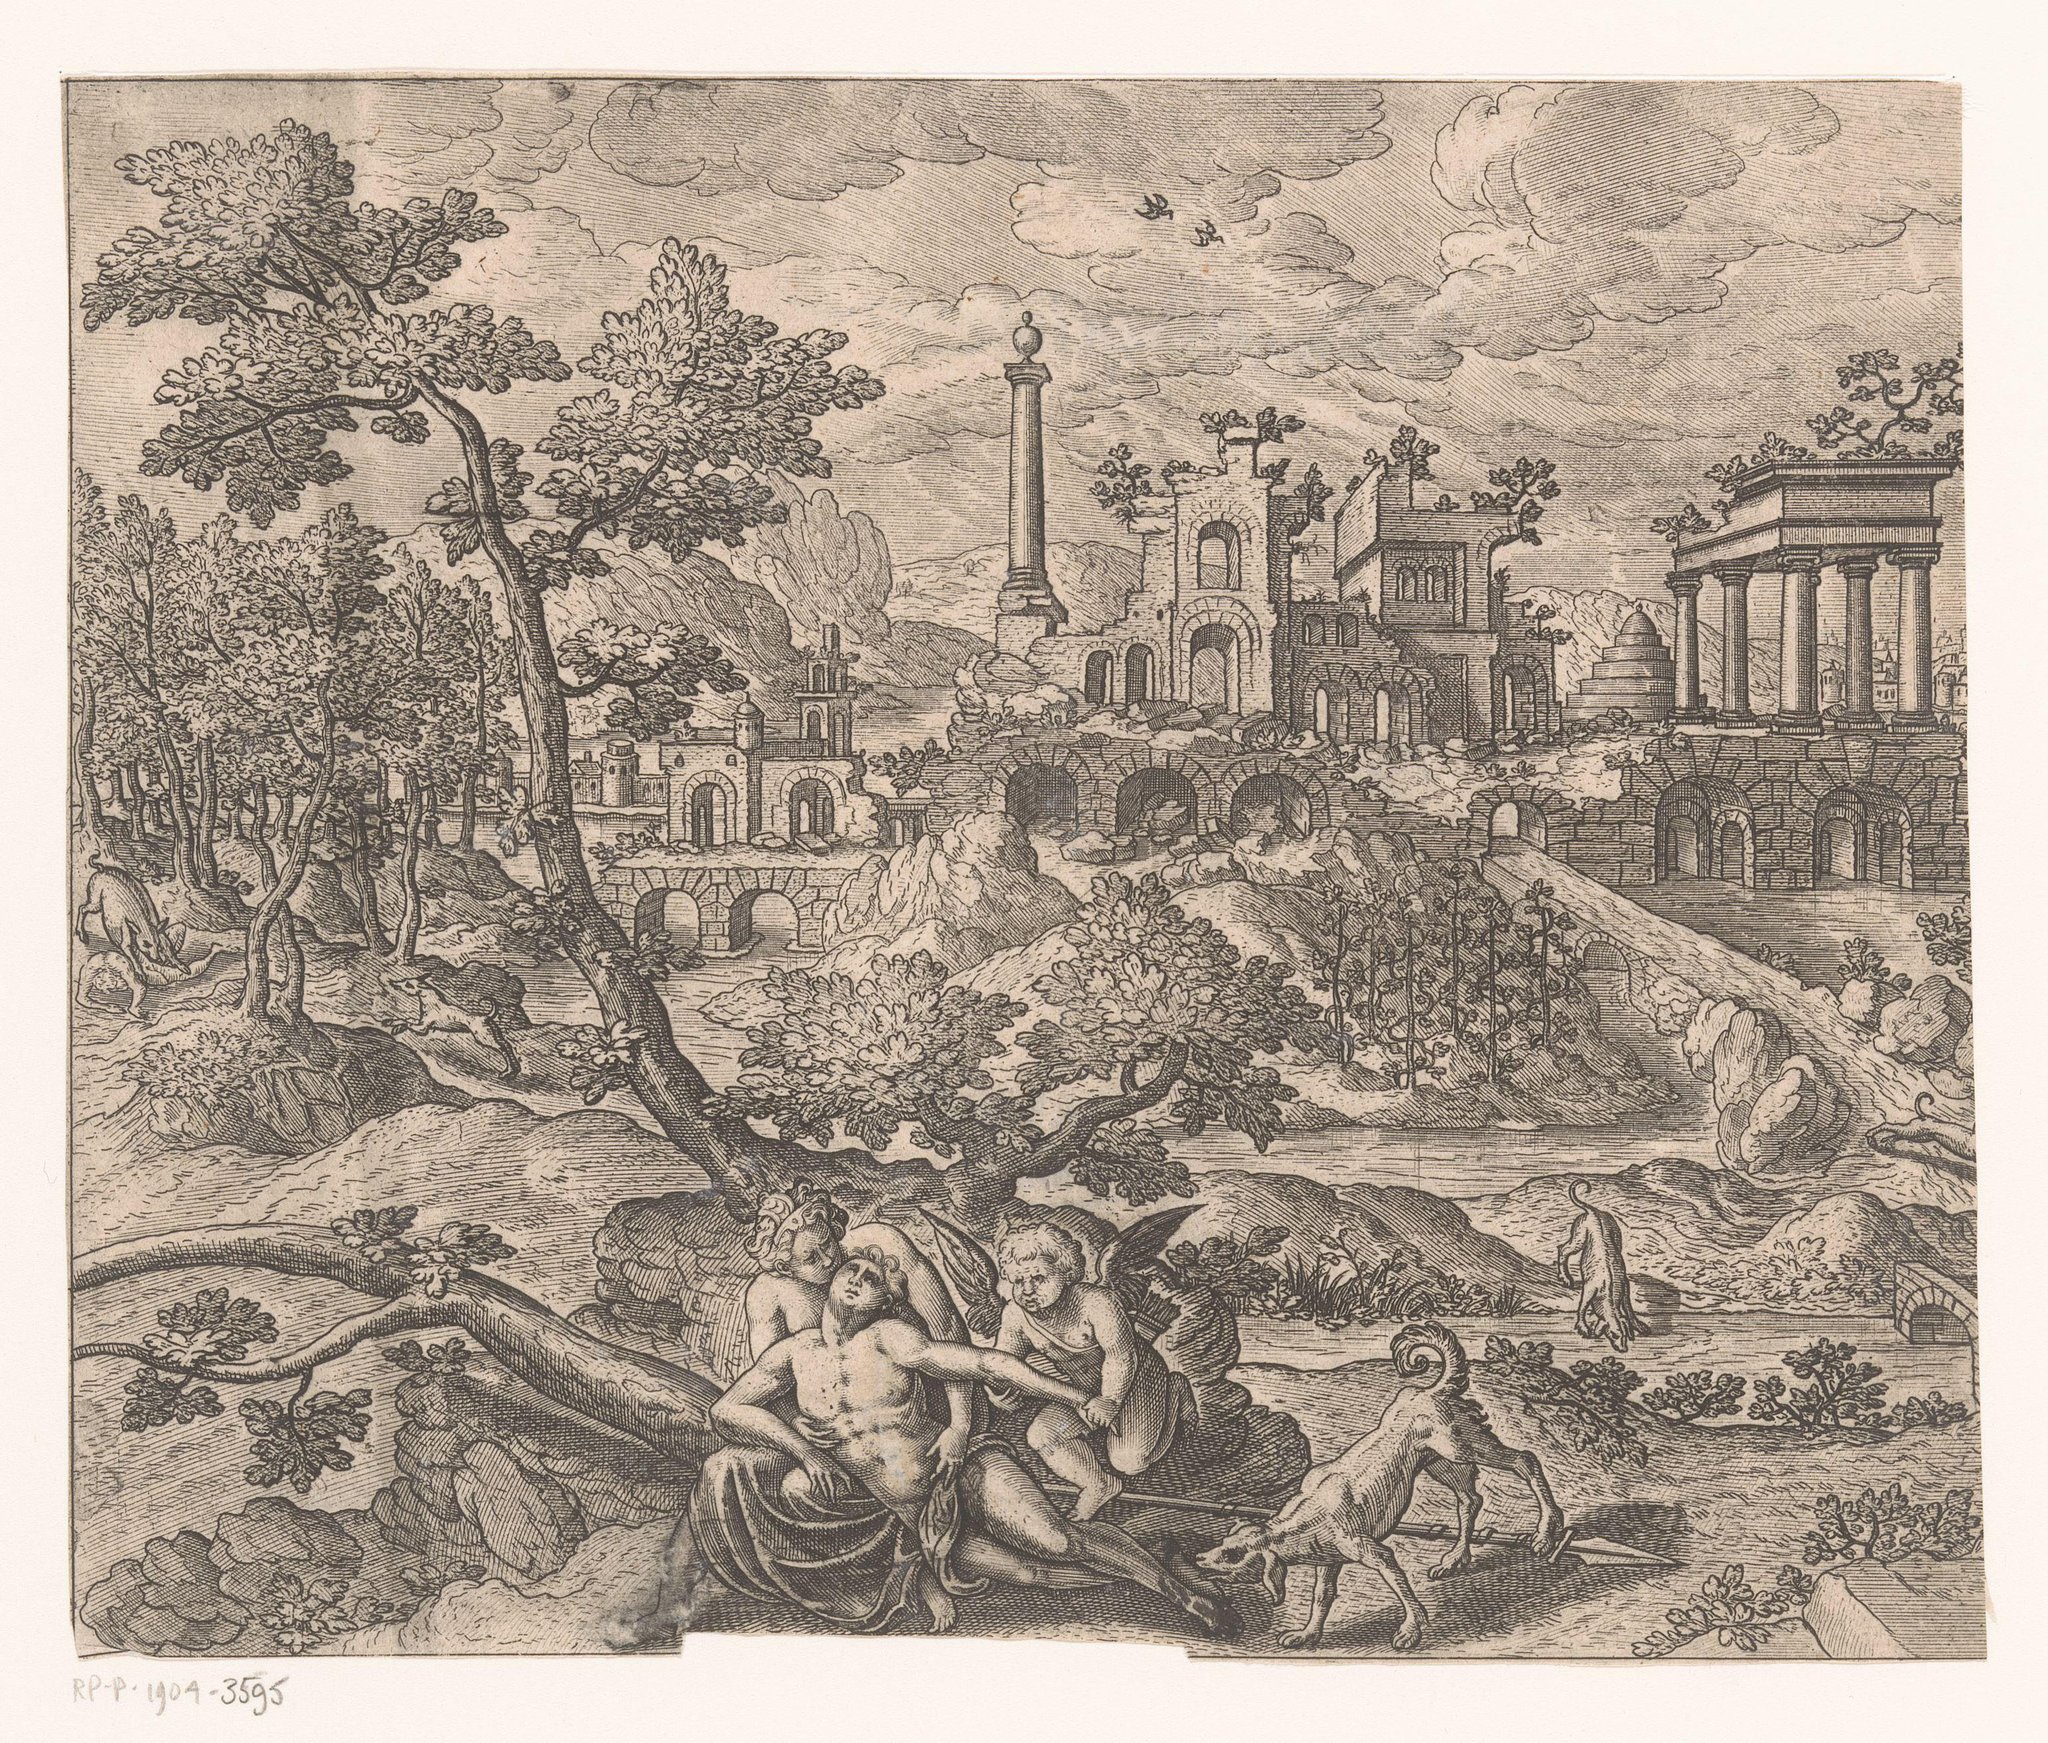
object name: print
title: Venus beweent Adonis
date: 1540-1630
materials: paper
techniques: engraving, etching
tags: death of adonis: he is killed by a boar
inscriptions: inscription: ‘ch.bc.X/ P.v.d.B. 267’, collector's mark: Lugt 2228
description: Maakt deel uit van een twaalfdelige serie met de metamorfosen van Ovidius, verschenen in drie edities. De eerste werd uitgegeven door Gerard de Jode, de tweede door Caes Jansz. Visscher en de derde door Jan Philipsz. Schabaelje.